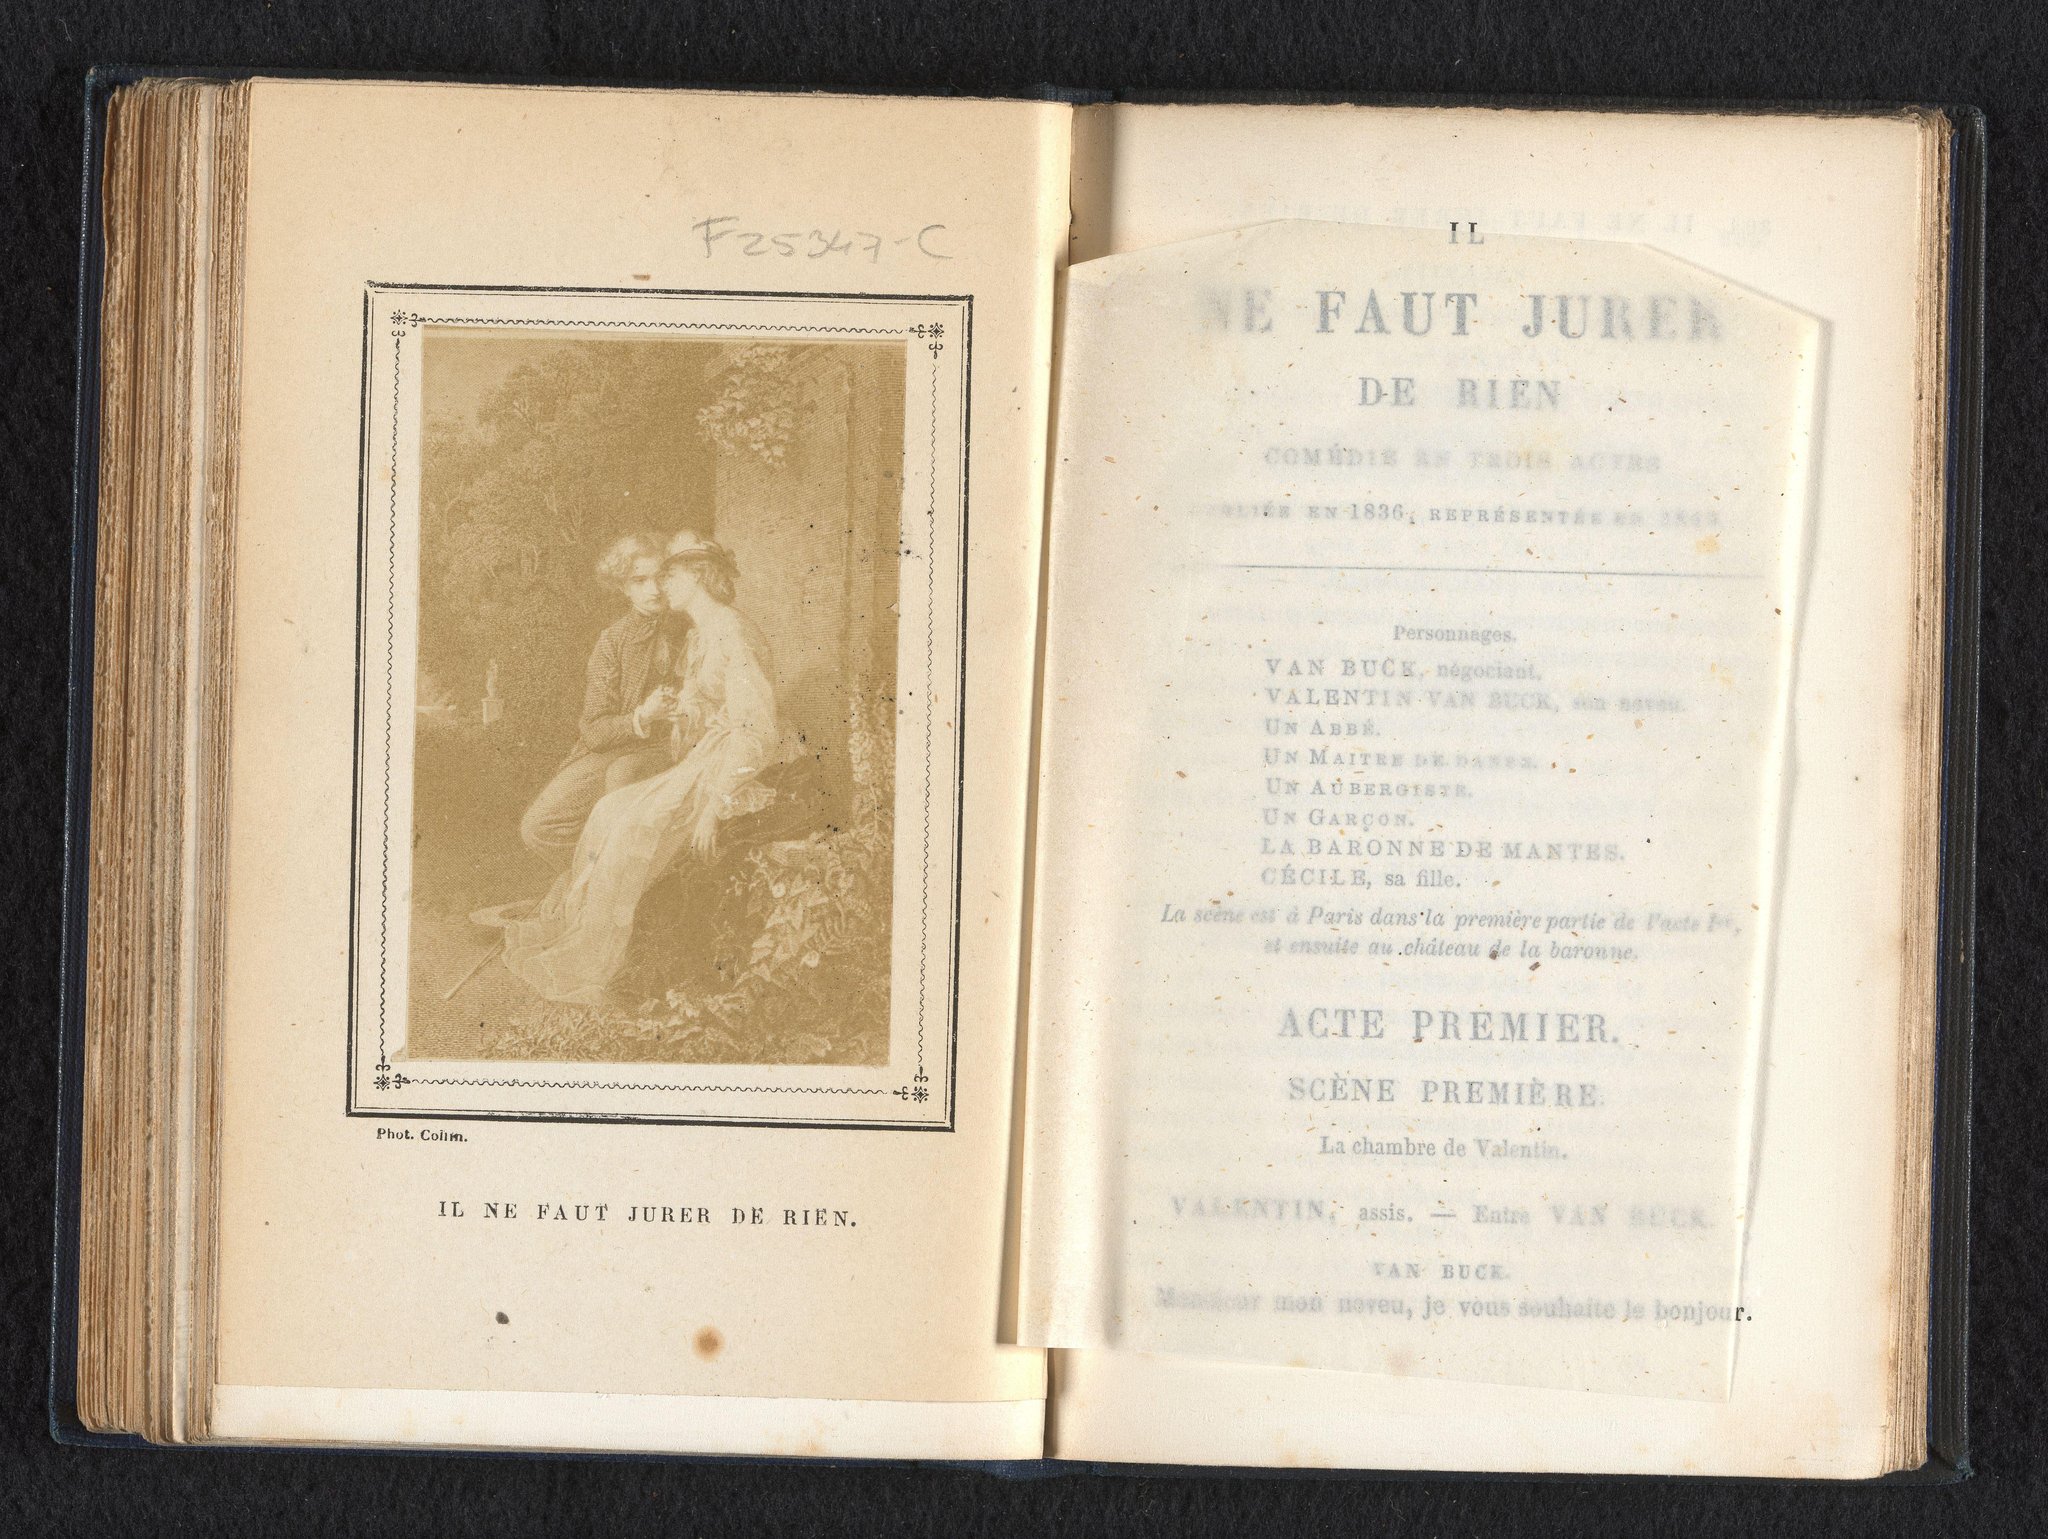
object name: page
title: Fotoreproductie van de gravure Il ne faut jurer de rien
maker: collin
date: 1852-1867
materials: paper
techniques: albumen print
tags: print, e.g.: engraving, etching, lithograph